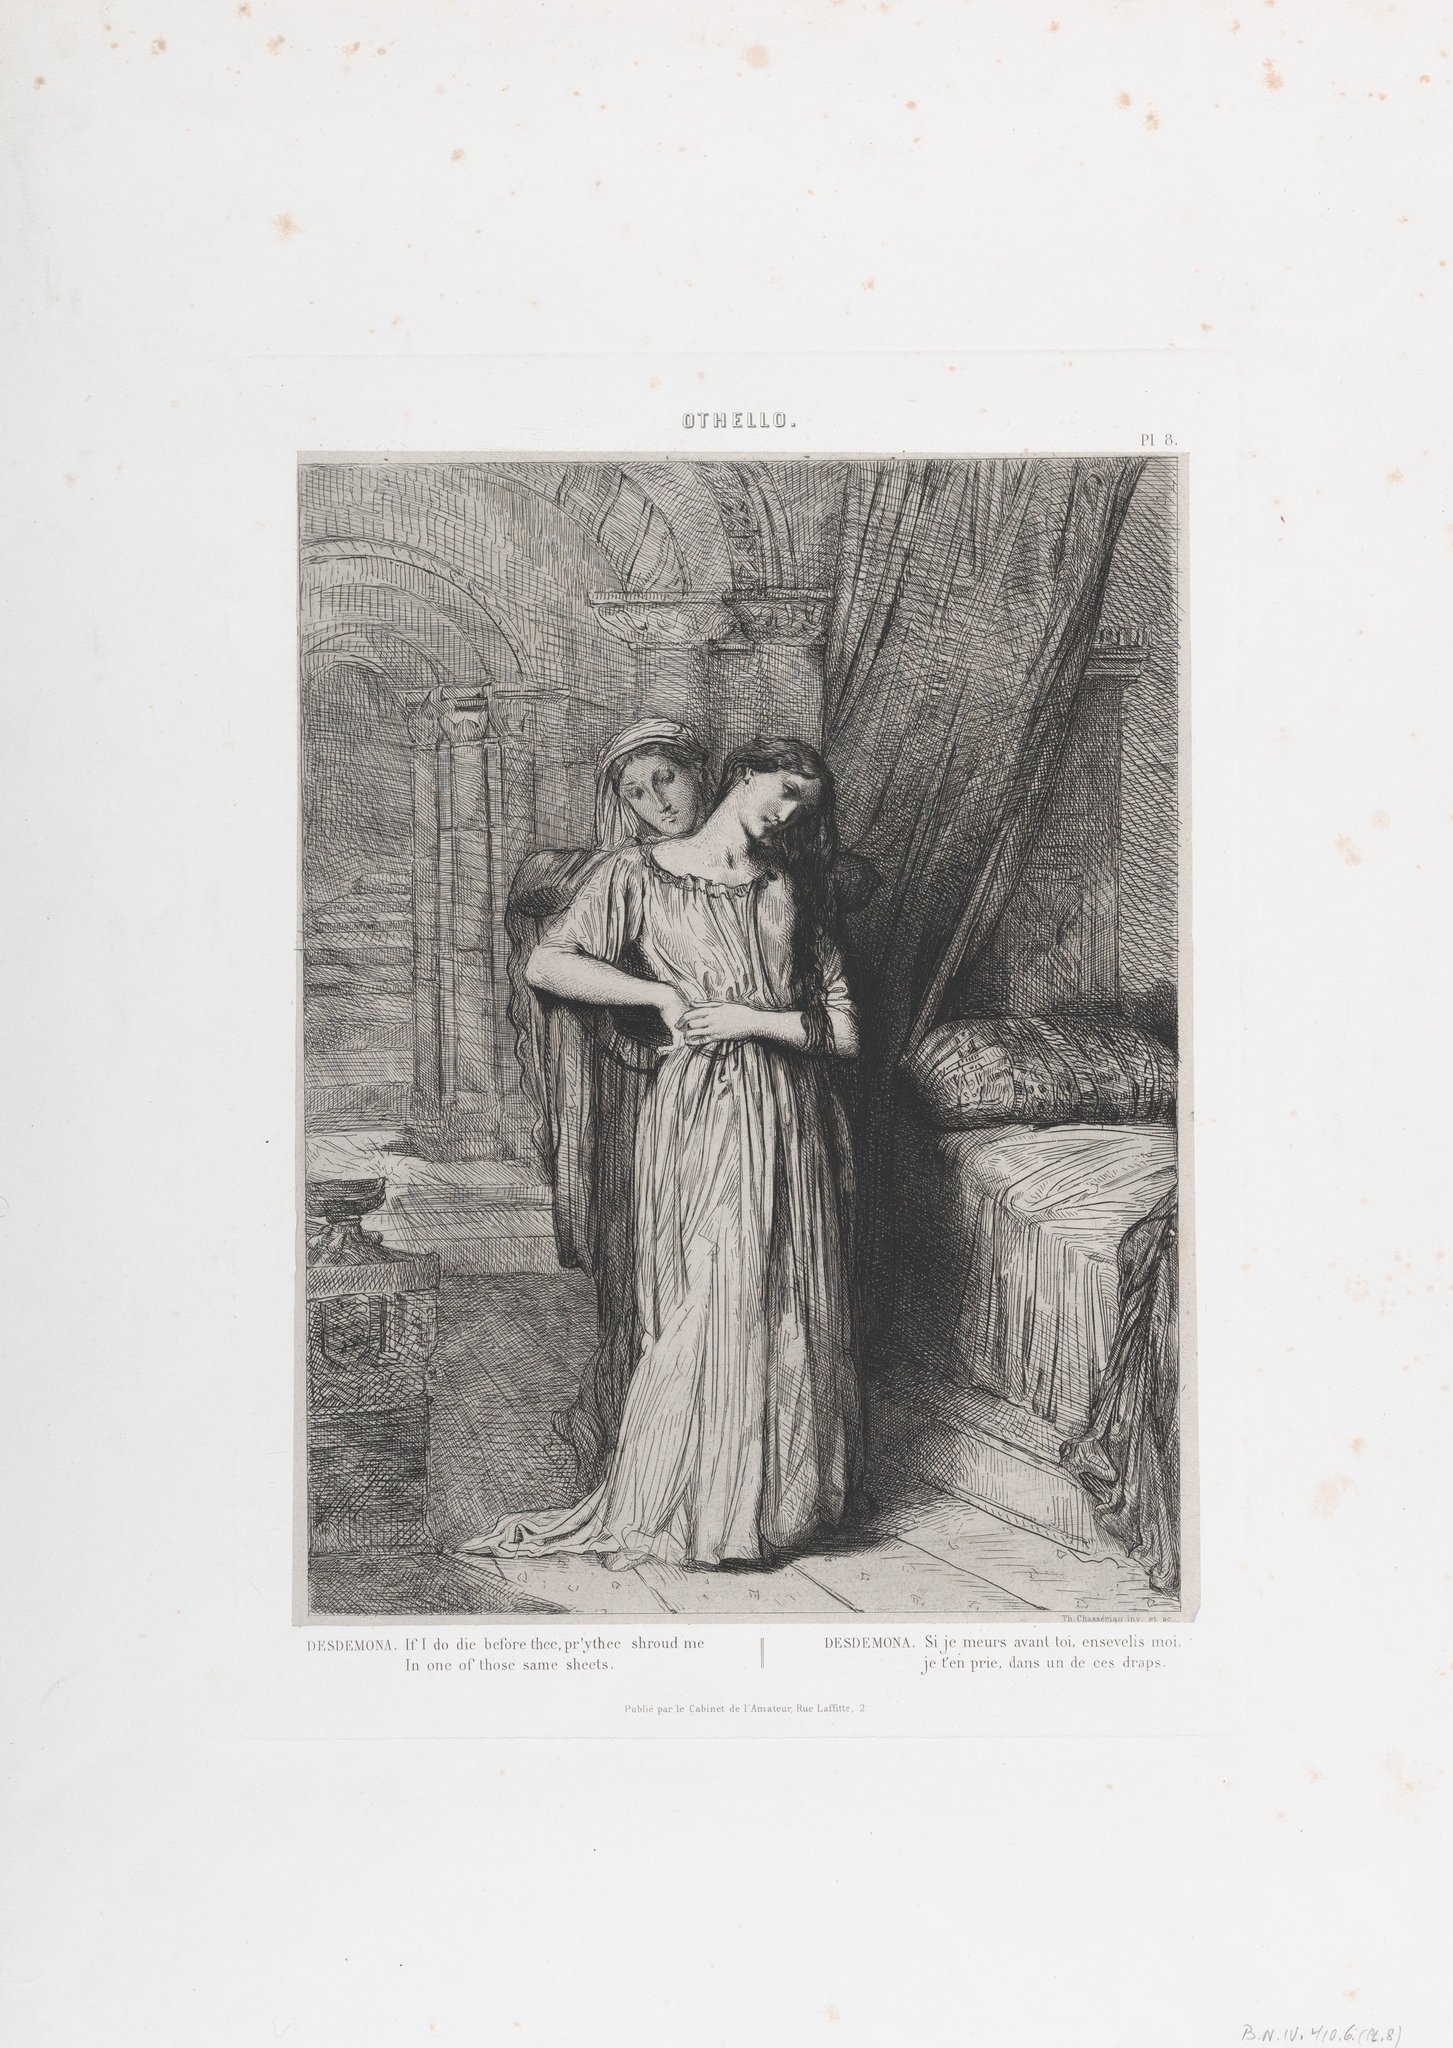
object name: print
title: "If I do die before thee, pr'ythee shroud me in one of those same sheets": plate 8 from Othello (Act 4, Scene 3)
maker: théodore chassériau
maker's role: artist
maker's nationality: french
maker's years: 1819-1856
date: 1844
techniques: printmaking, drypoint, engraving, etching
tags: shakespeare,women,beds